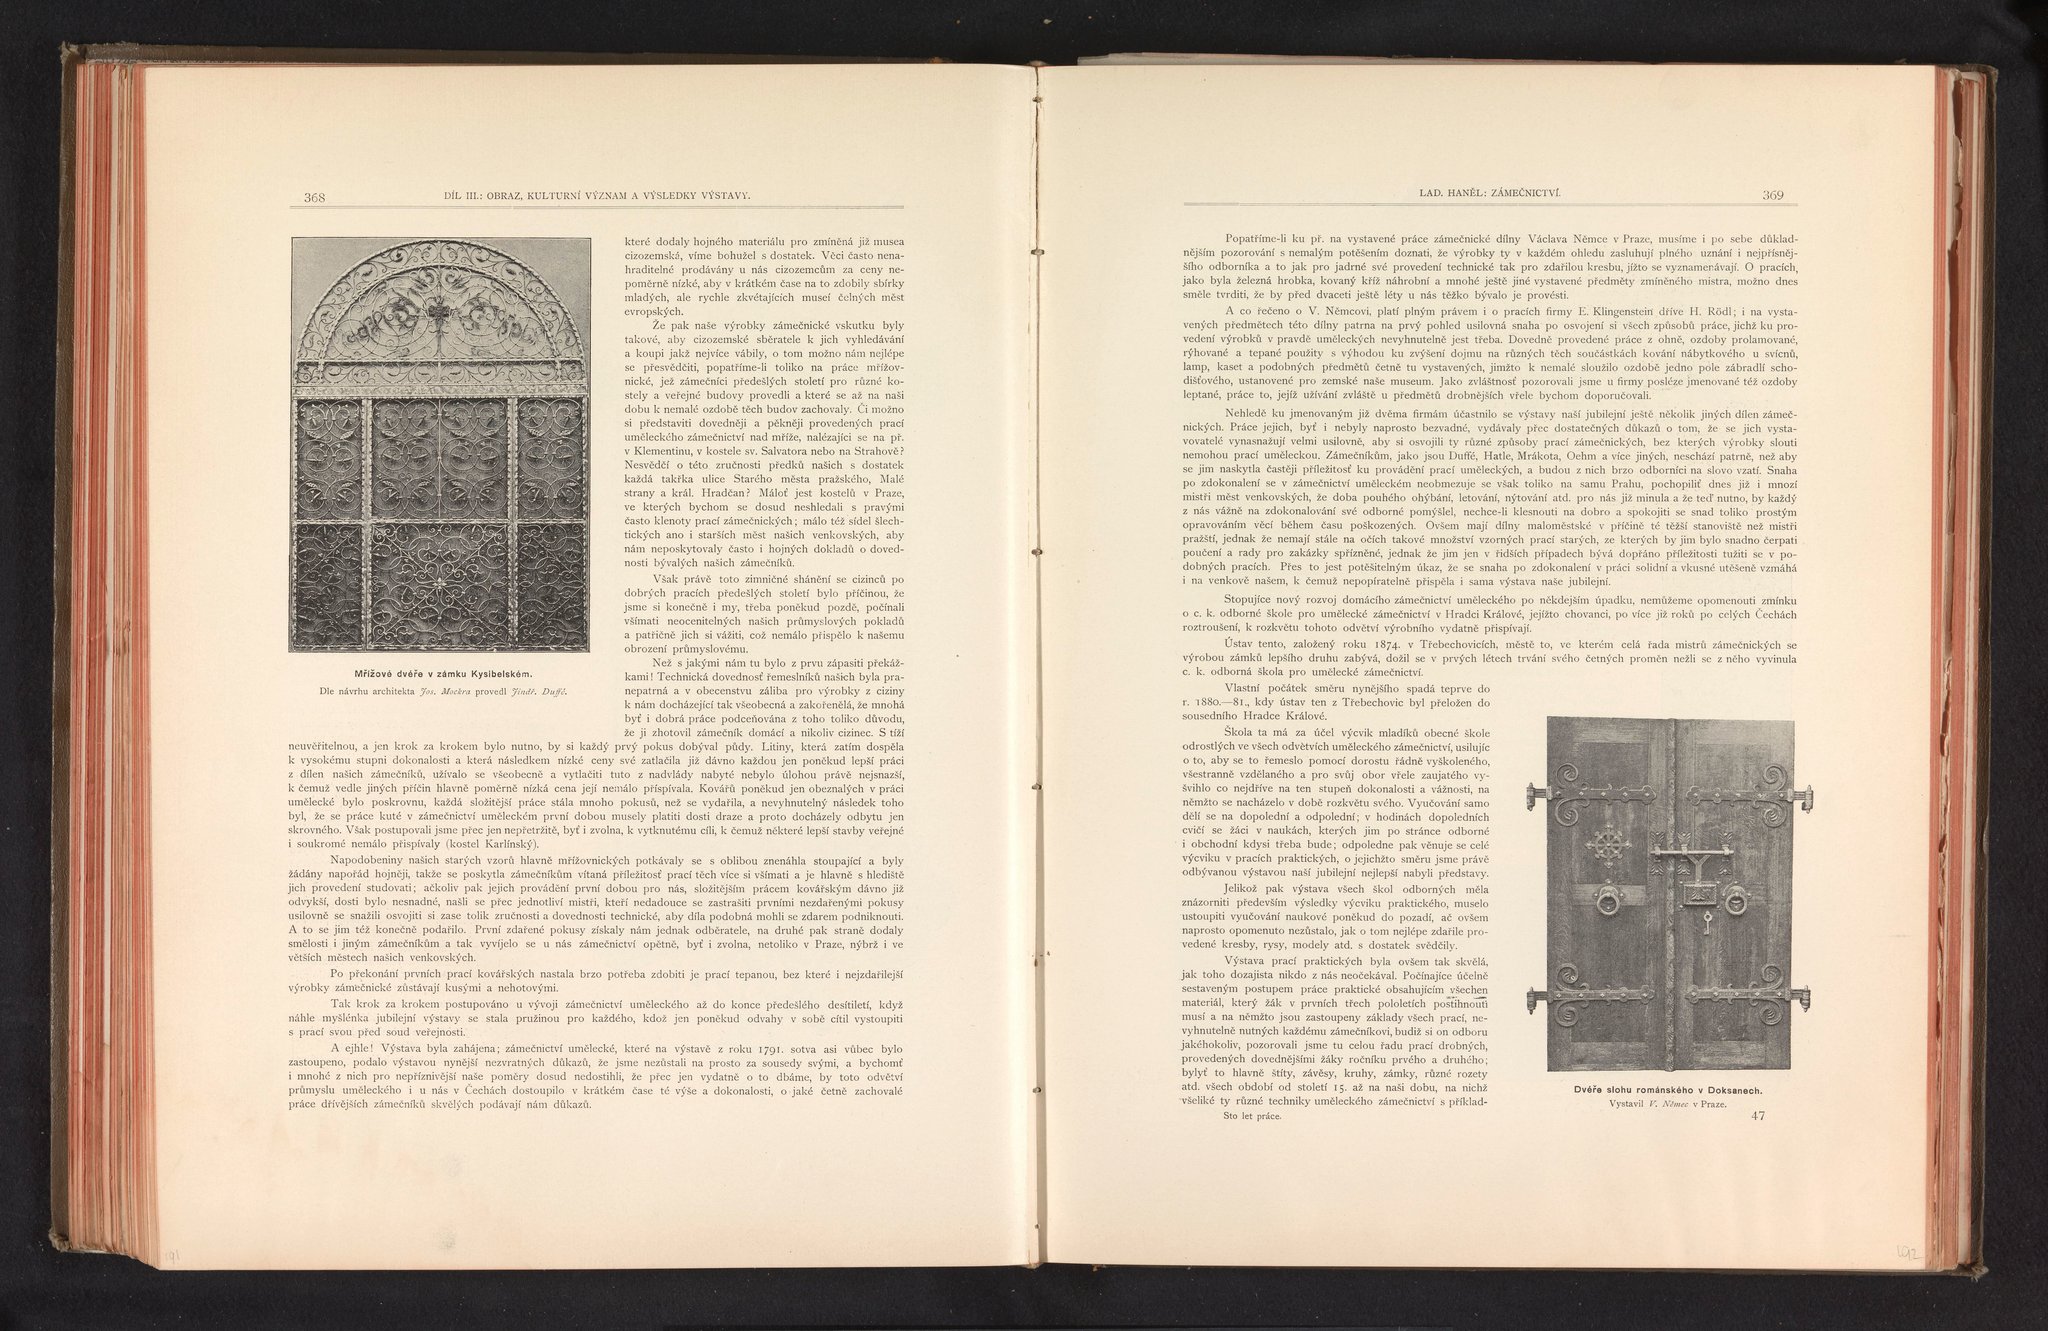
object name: photomechanical print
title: Poort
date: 1890-1895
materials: paper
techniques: autotype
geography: prague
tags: gate, entrance